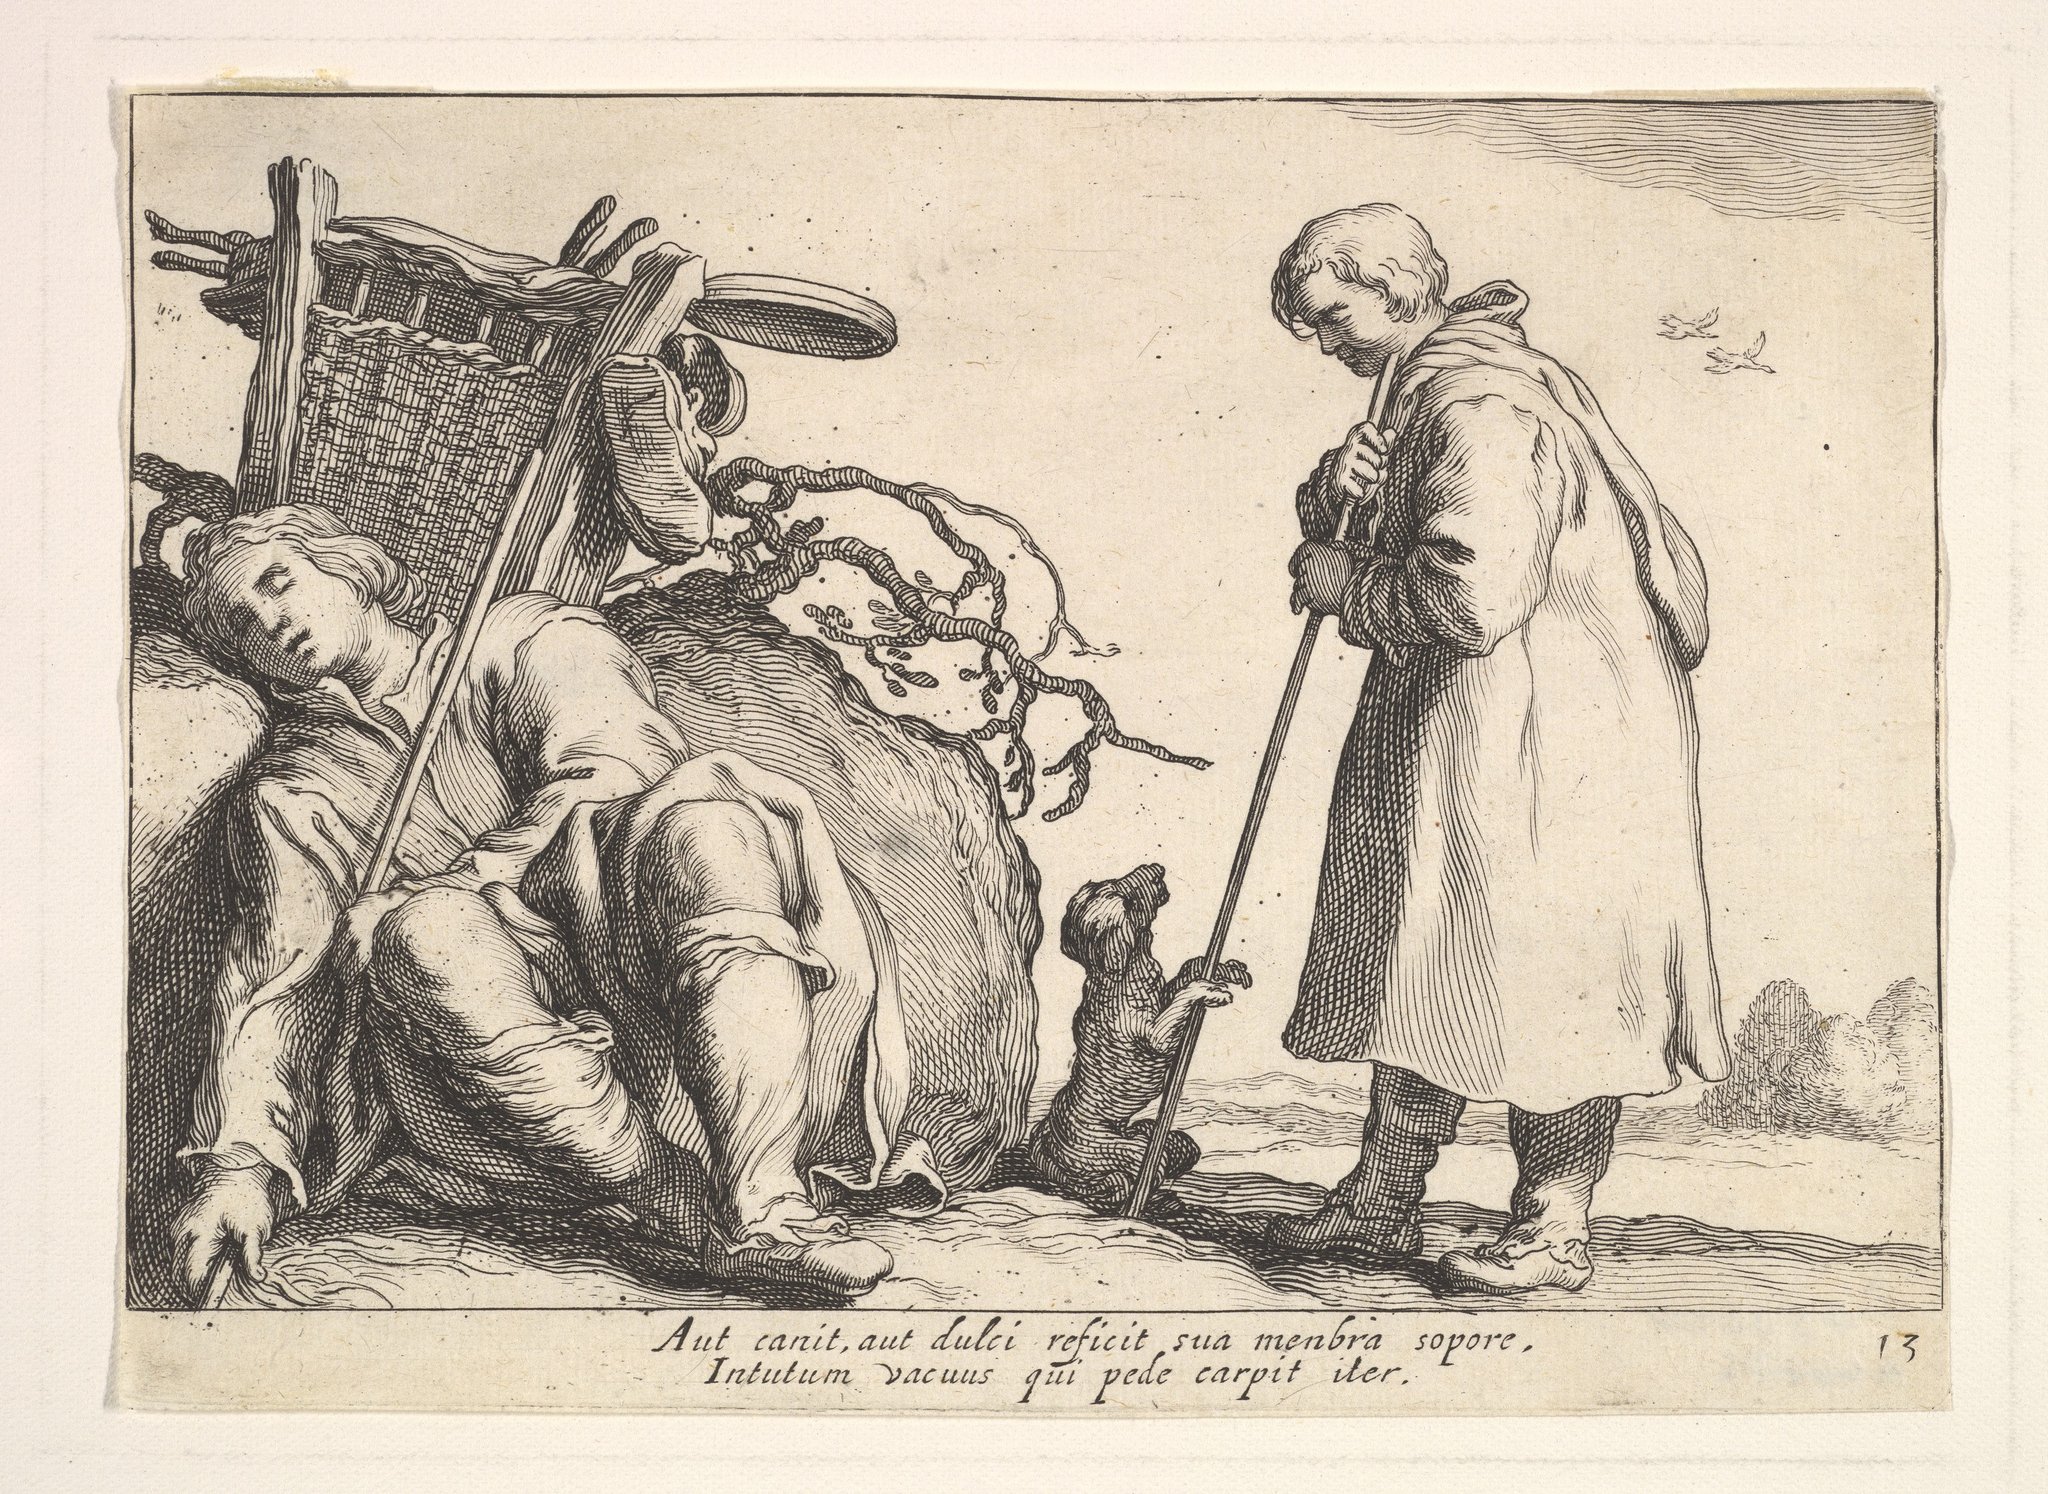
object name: print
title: Pleasures of Occupation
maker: cornelis bloemaert (ii)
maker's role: artist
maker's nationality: dutch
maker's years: 1603-1684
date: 1610-1684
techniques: engraving, etching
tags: sleeping,men,dogs